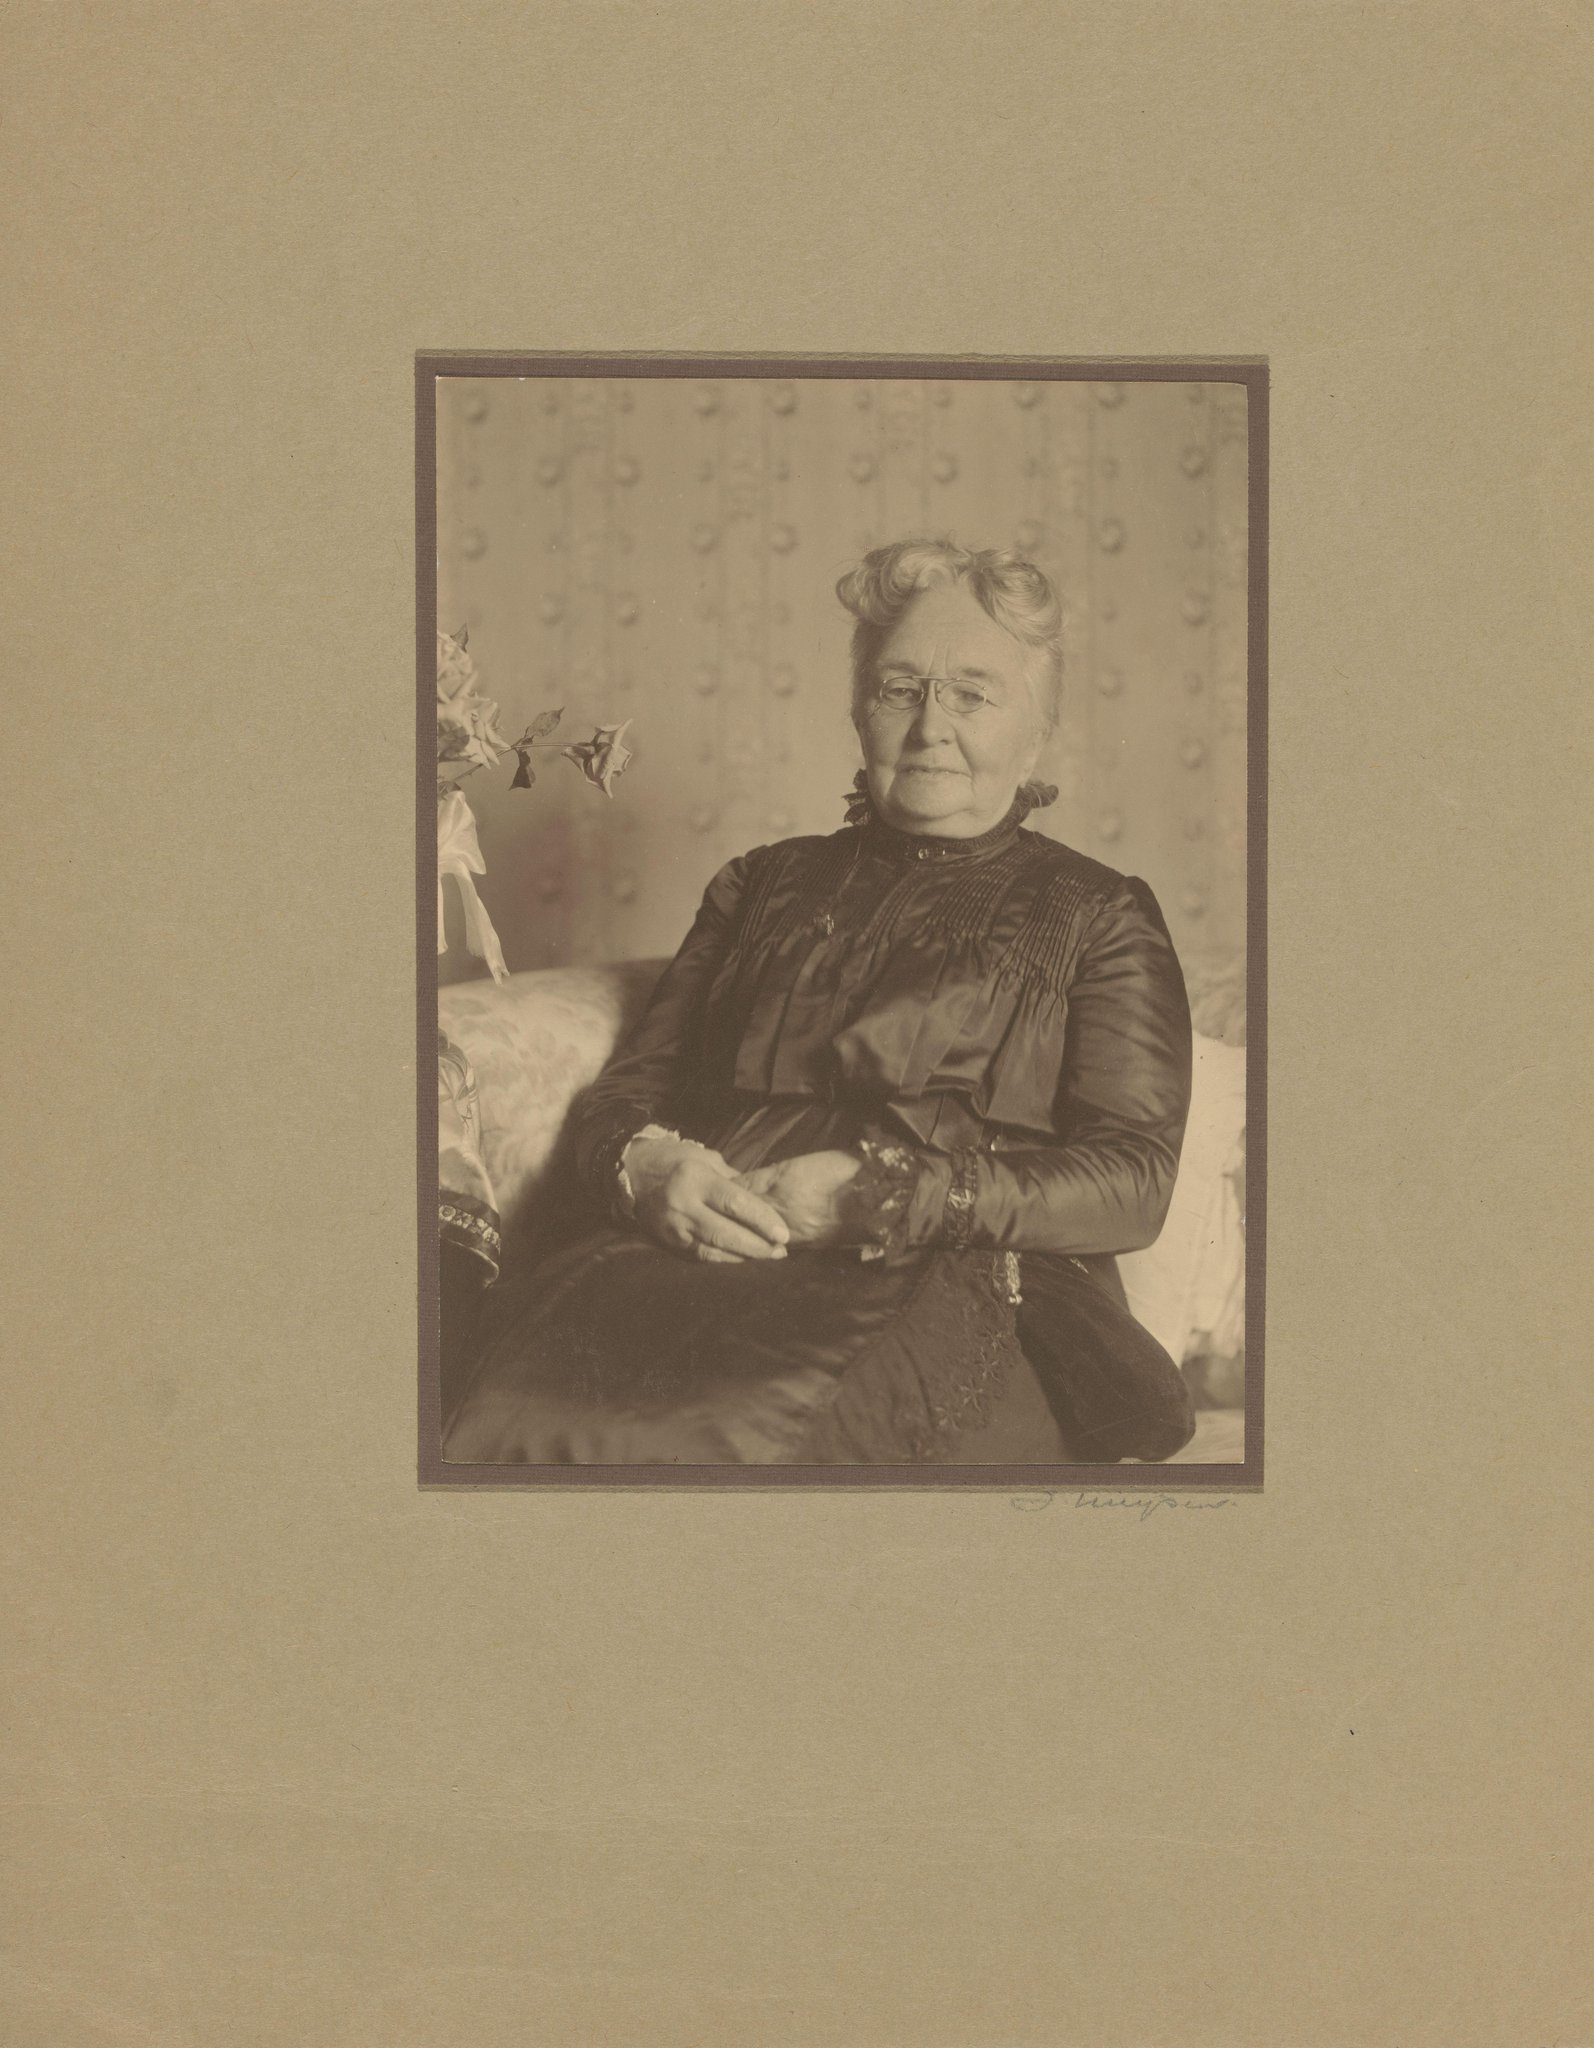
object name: photograph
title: Portret van een onbekende vrouw, vermoedelijk gerelateerd aan de familie Marmelstein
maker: j. kuipers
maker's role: fotograaf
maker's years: 1845-1925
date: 1900-1940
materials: paper, cardboard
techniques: gelatin silver print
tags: adult woman, child, historical persons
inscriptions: signature: ‘J. Kuipers’